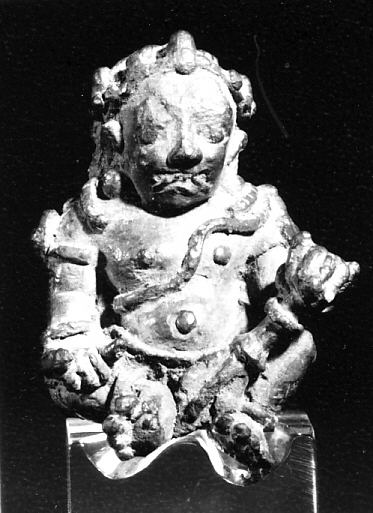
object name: figure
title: Seated Male with Vajra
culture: indonesian, javanese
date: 901-1100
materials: bronze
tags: men